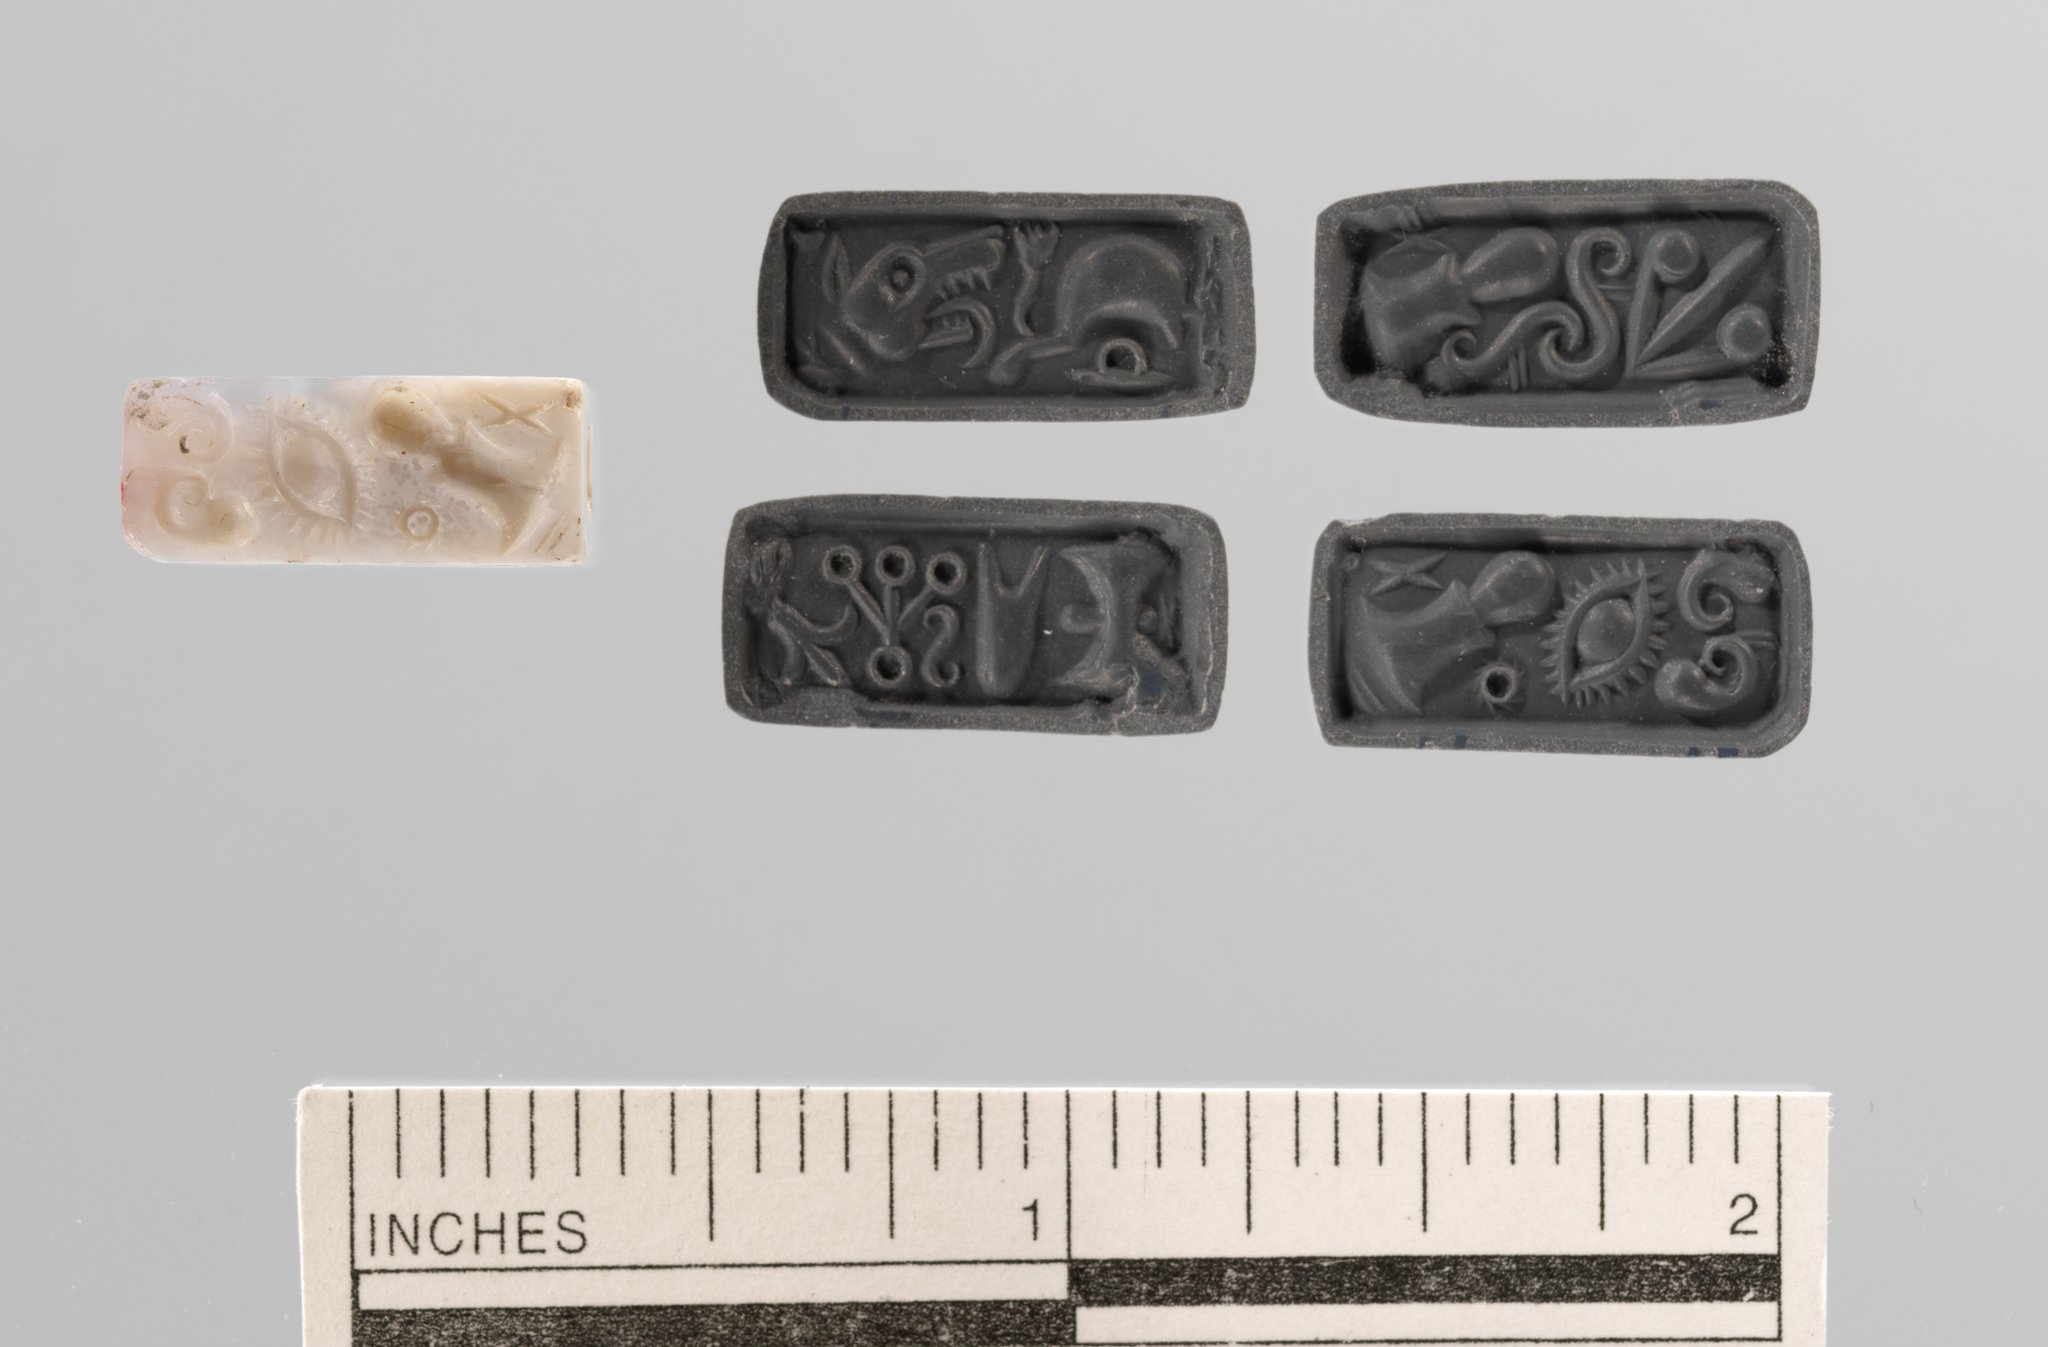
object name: prism, rectangular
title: Burnt Chalcedony Rectangular Prism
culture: minoan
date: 1800-1700 BCE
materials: stone